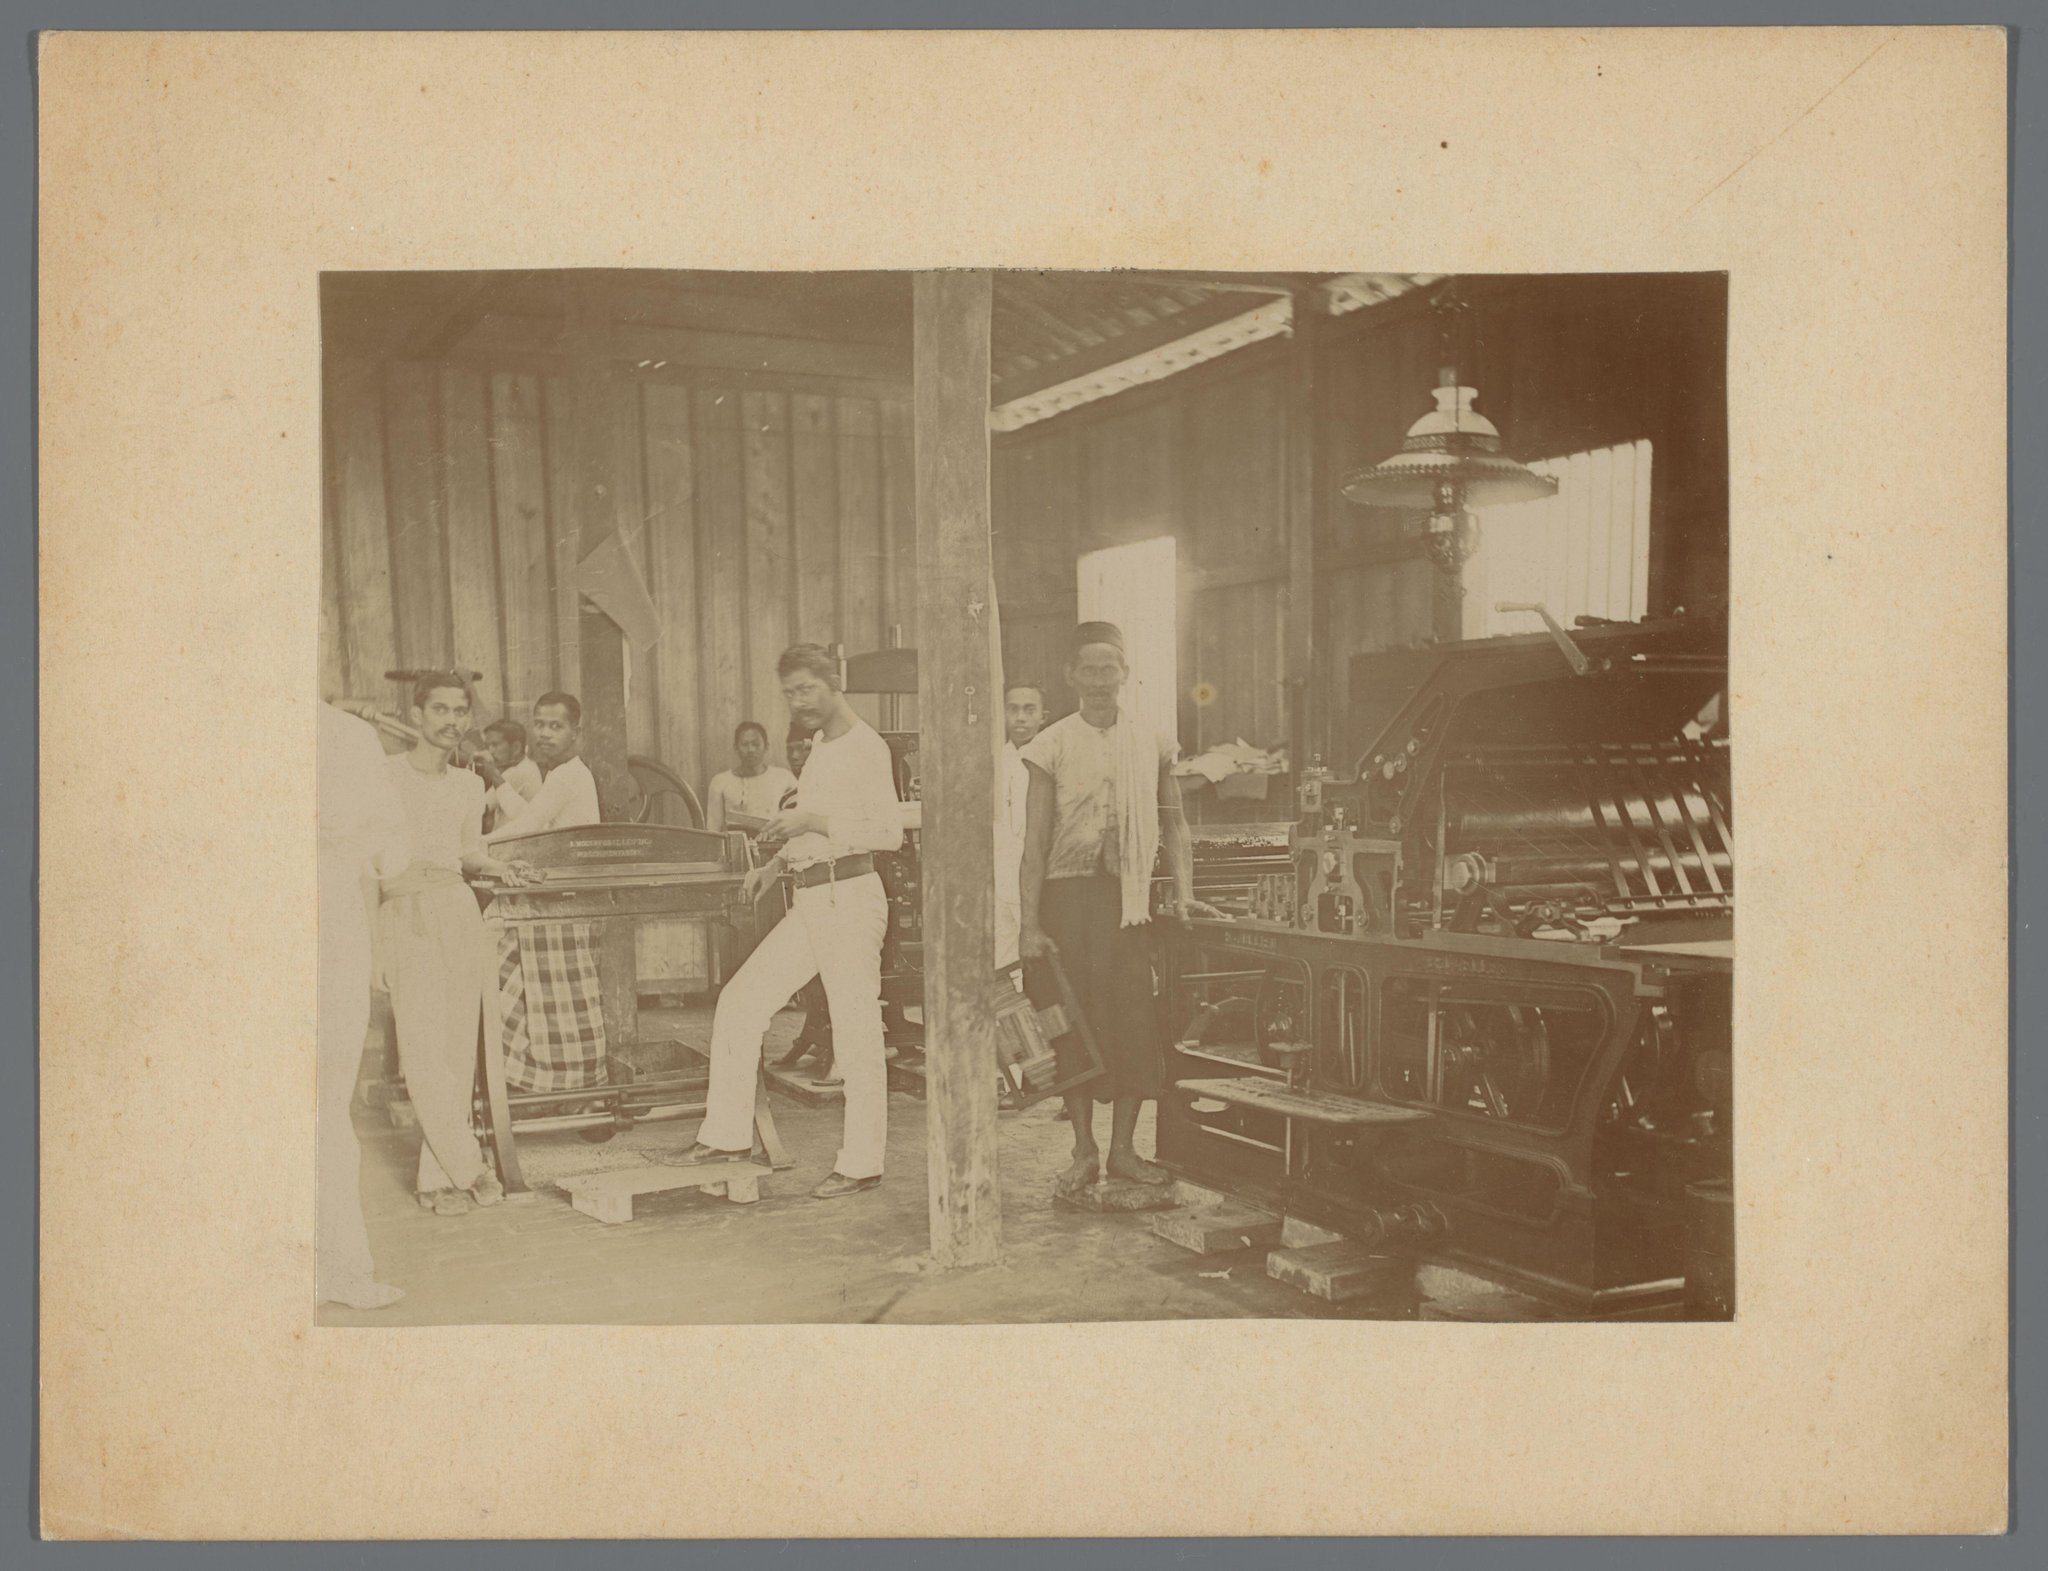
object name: photograph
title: Drukkerij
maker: Anonymous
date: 1900-1940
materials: cardboard, photographic support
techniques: collodion silver print, gelatin silver print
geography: sumatra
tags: sumatra, dutch east indies, the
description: Gezicht in een drukkerij met enkele werknemers staande naast een drukpers. Foto opgeplakt op karton. Onderdeel van een groep van 14 losse foto's genomen op Midden- en Zuid-Sumatra in de periode ca. 1900-1940.